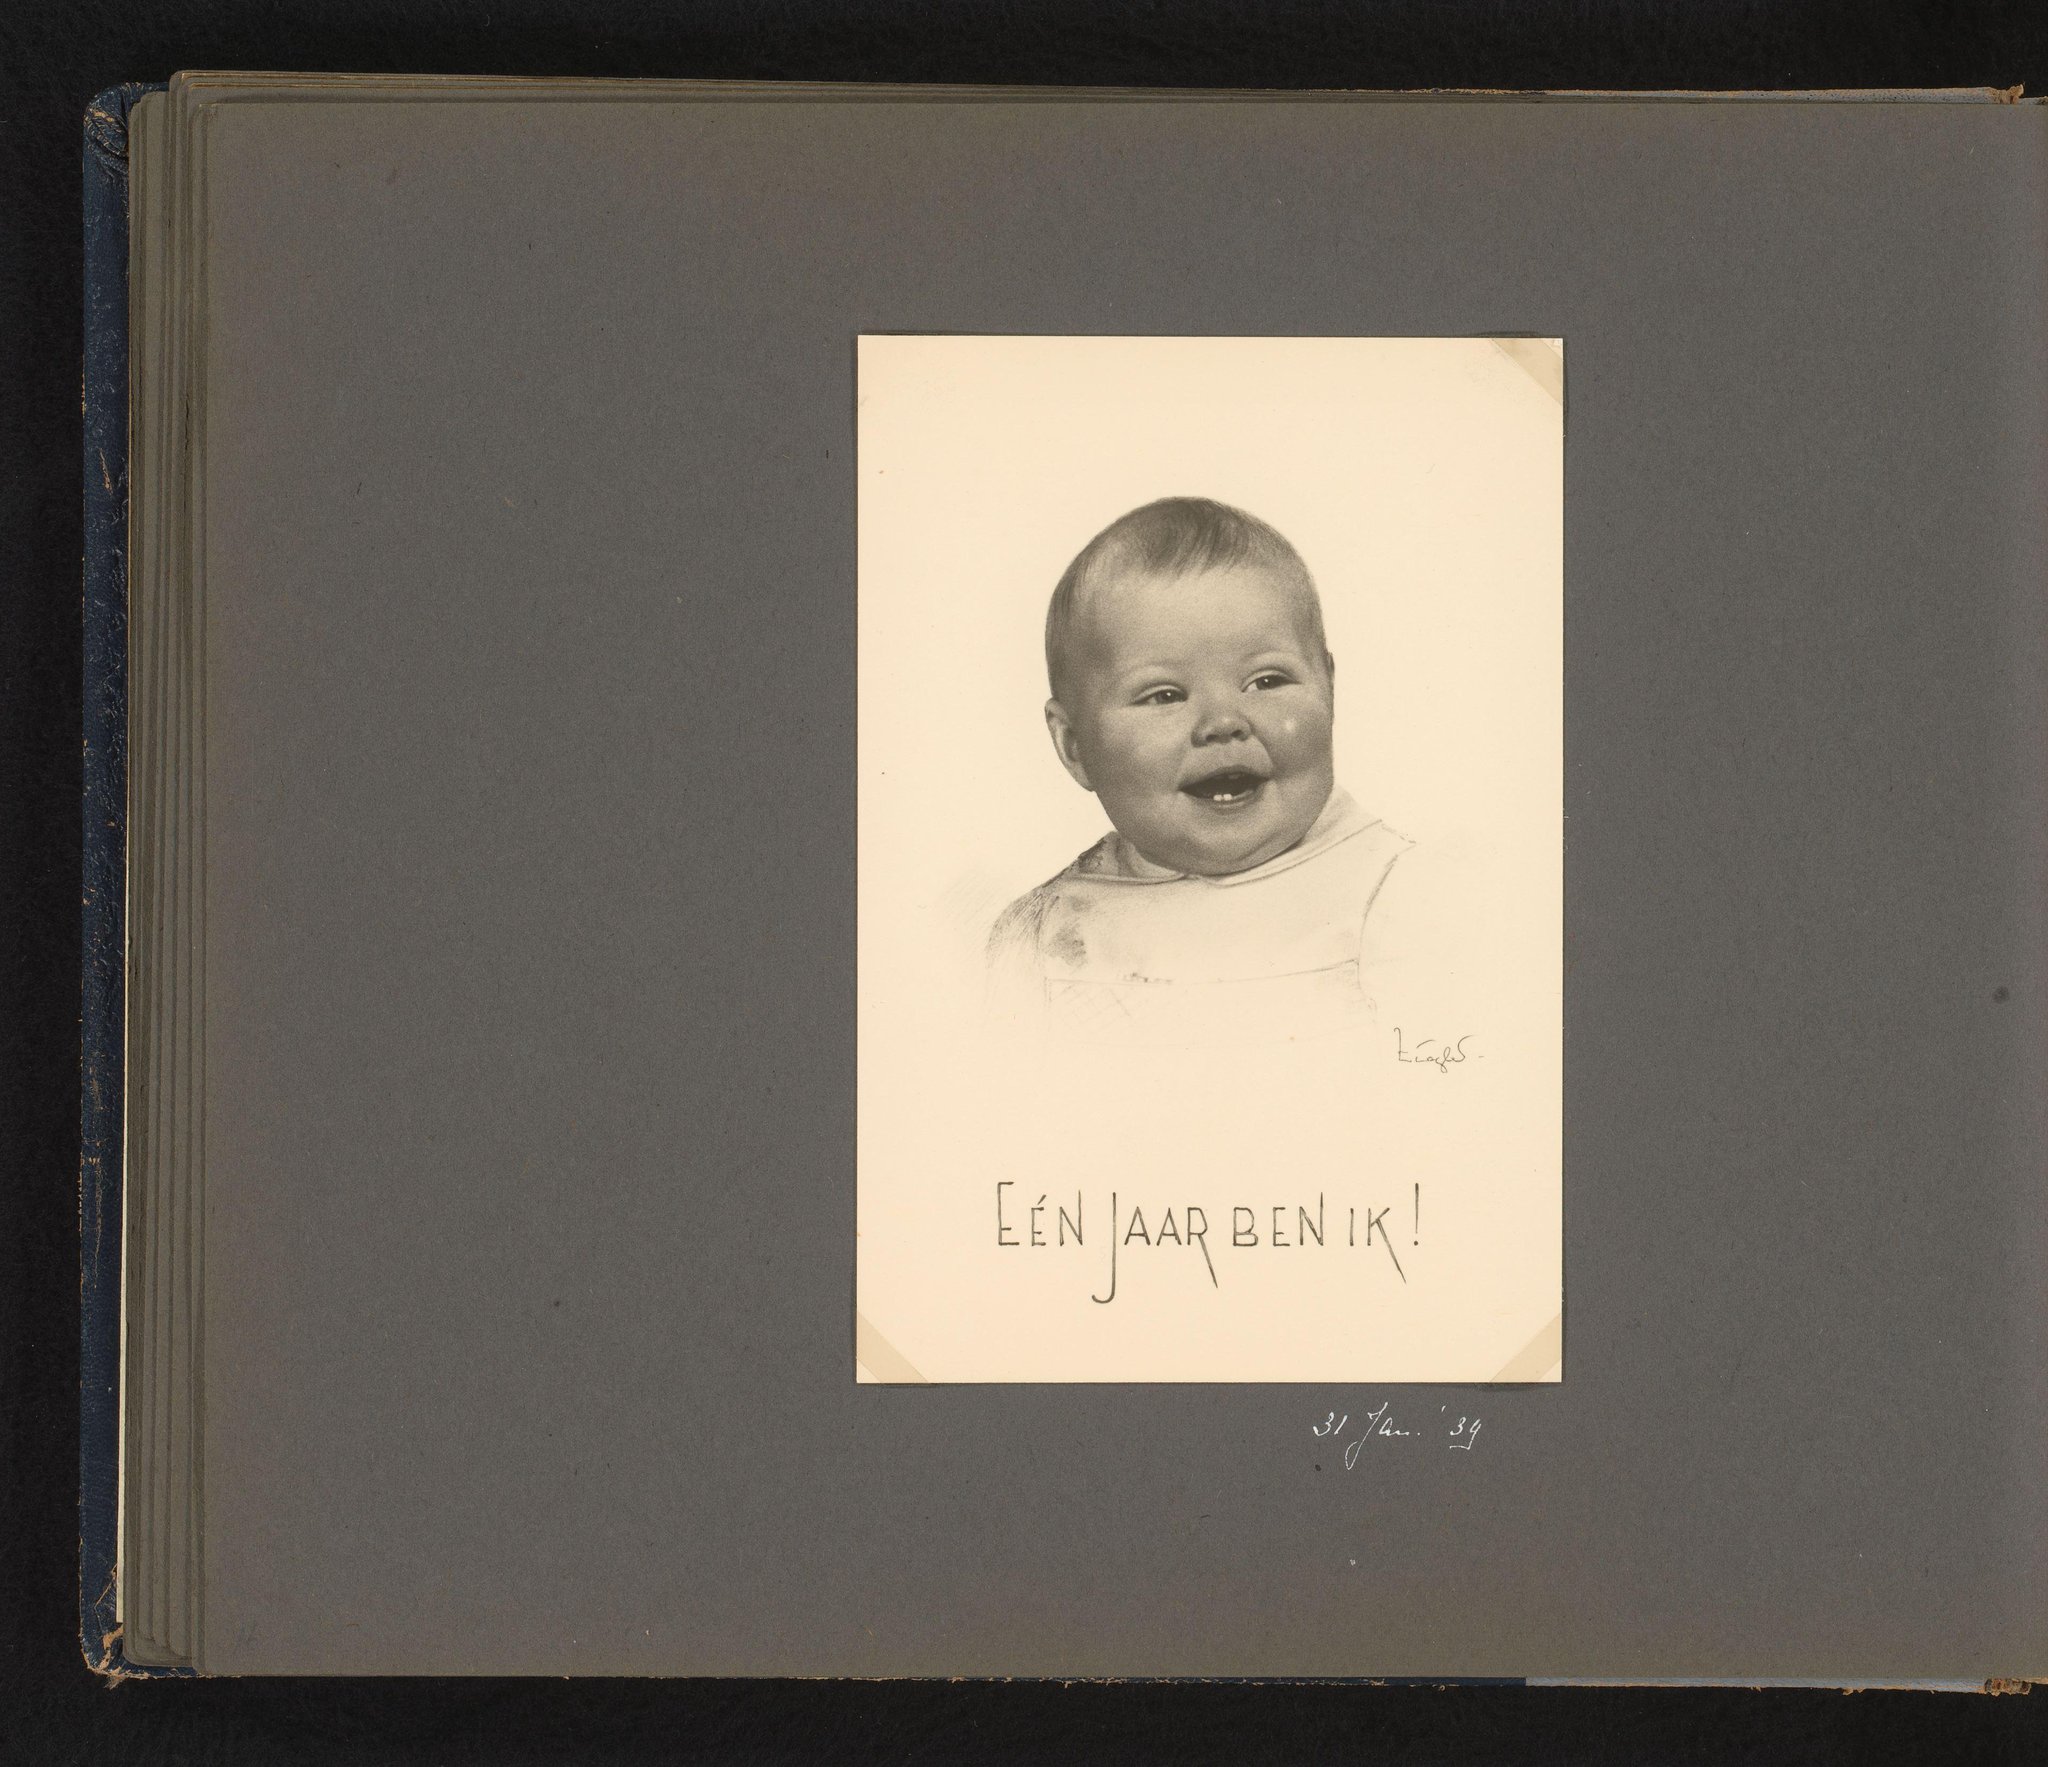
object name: album leaf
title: Eén jaar ben ik!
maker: franz ziegler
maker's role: fotograaf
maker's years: 1893-1939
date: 1901-1939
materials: cardboard, photographic support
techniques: gelatin silver print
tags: beatrix (koningin der nederlanden), infant, baby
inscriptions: date: ‘31 Jan. '39’, number: ‘1801’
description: Albumblad met een foto van prinses Beatrix, bij haar eerste verjaardag op 31 januari 1939. Beschreven op verso. Onderdeel van fotoalbum over het familieleven van de leden van het Koninklijk Huis tussen 1937-1945.